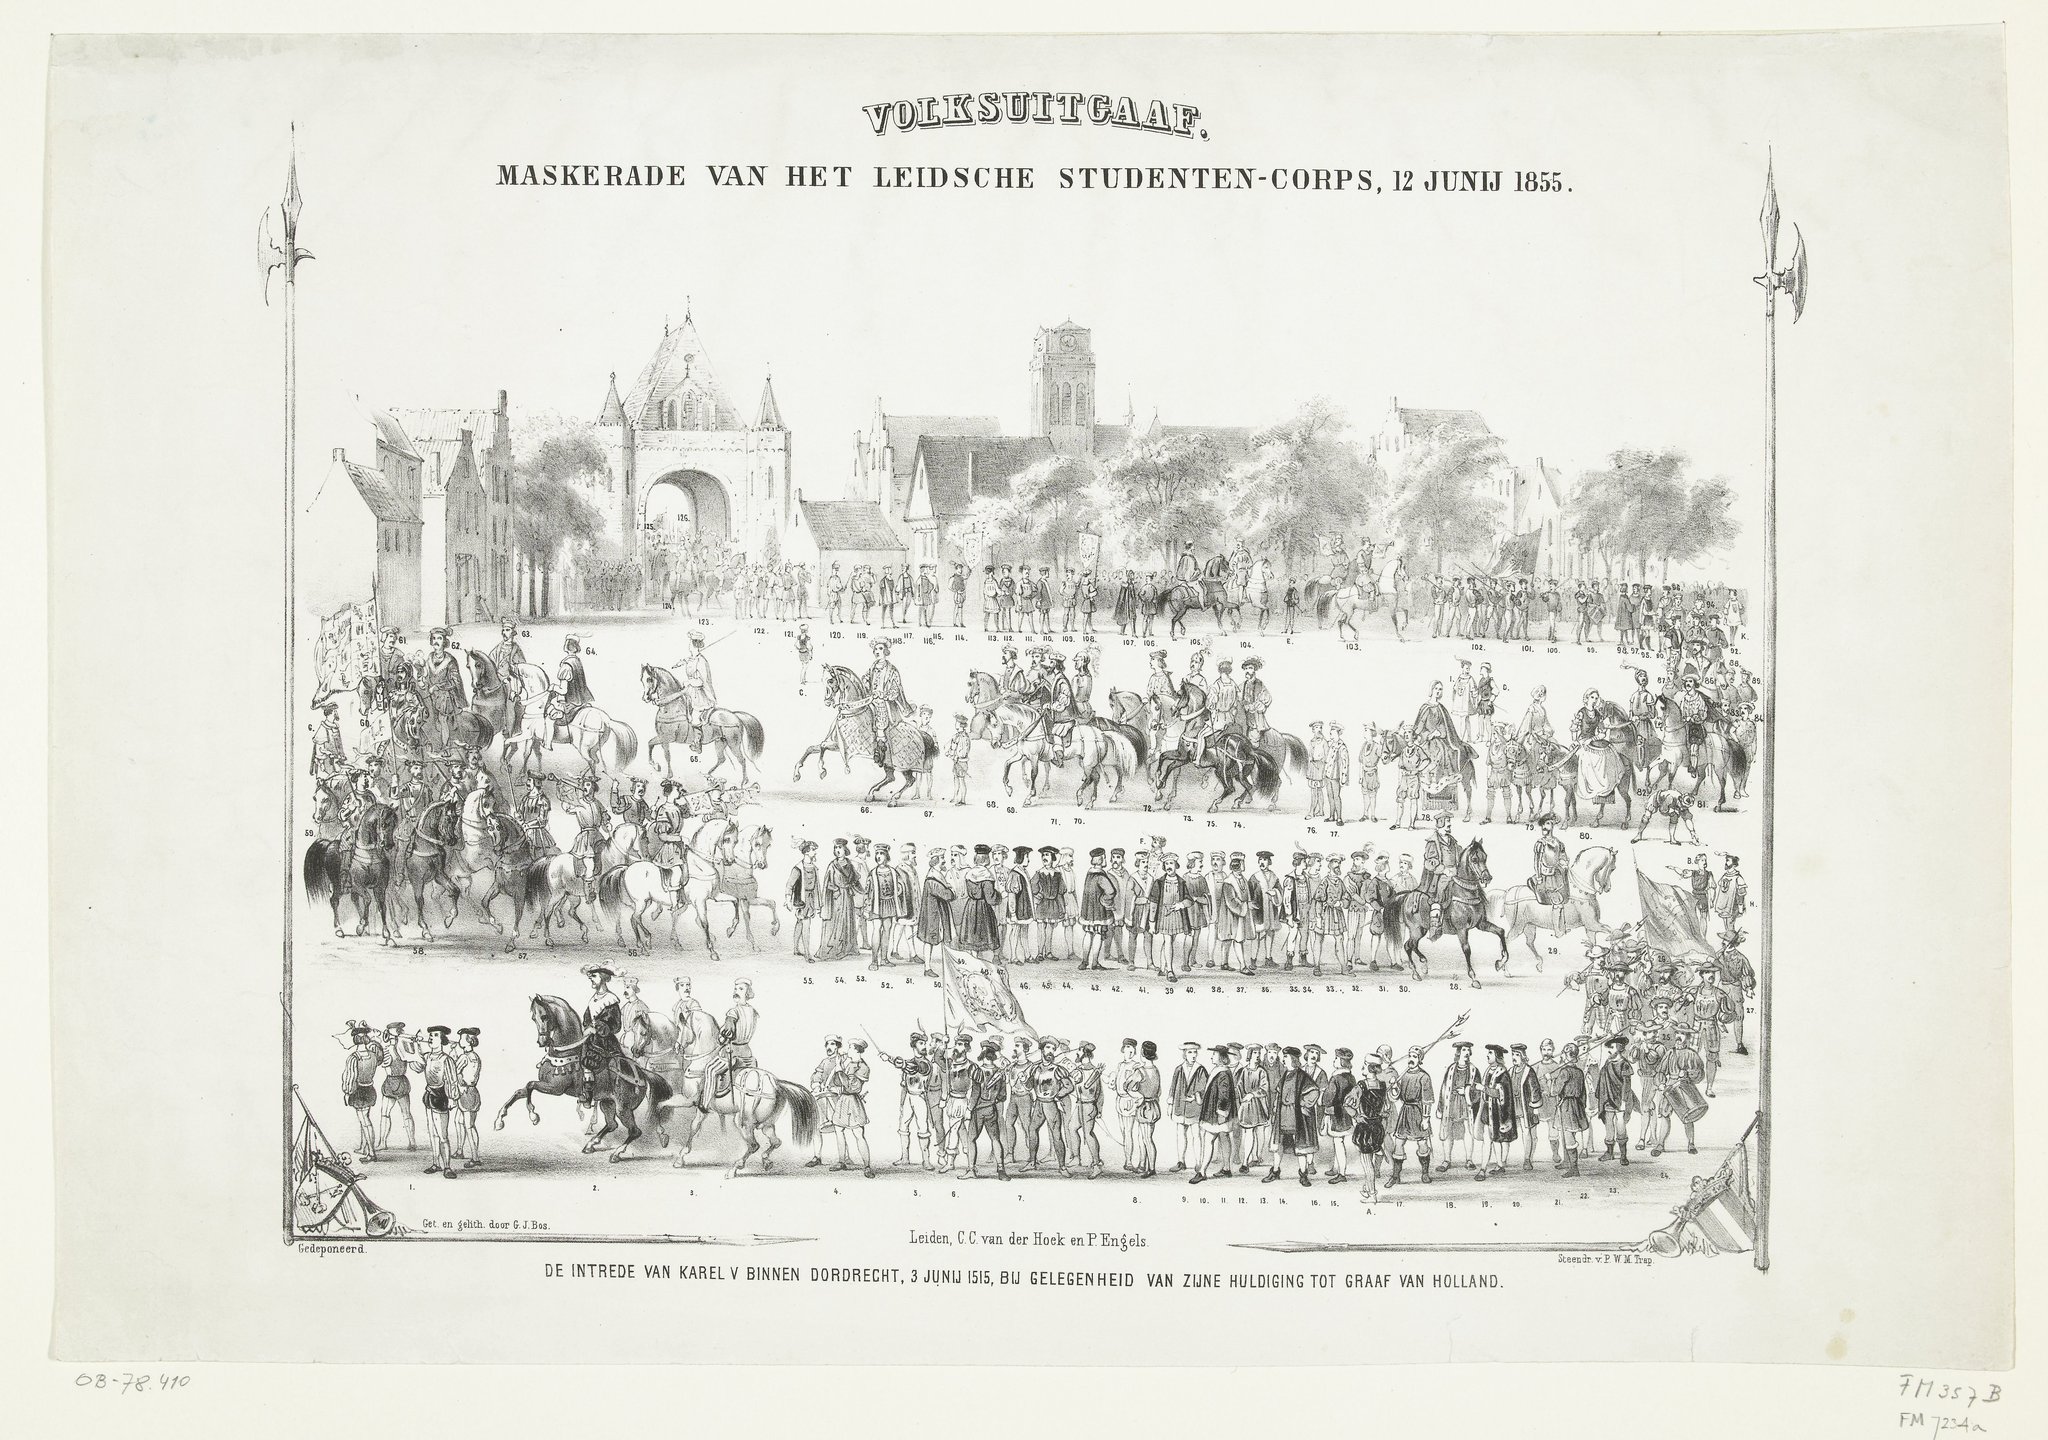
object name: history print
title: Gemaskerde optocht door het Leidse Studentencorps: intrede van keizer Karel V te Dordrecht, 1515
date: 1780-1795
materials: paper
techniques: lithograph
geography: netherlands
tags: charles v (holy roman emperor and king of spain), students' pageant, leiden, dordrecht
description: Gemaskerde optocht door het Leidse Studentencorps op 12 juni 1855. Uitgebeeld wordt de intrede van Karel V te Dordrecht op 3 juni 1515, bij de gelegenheid van zijn huldiging tot graaf van Holland.